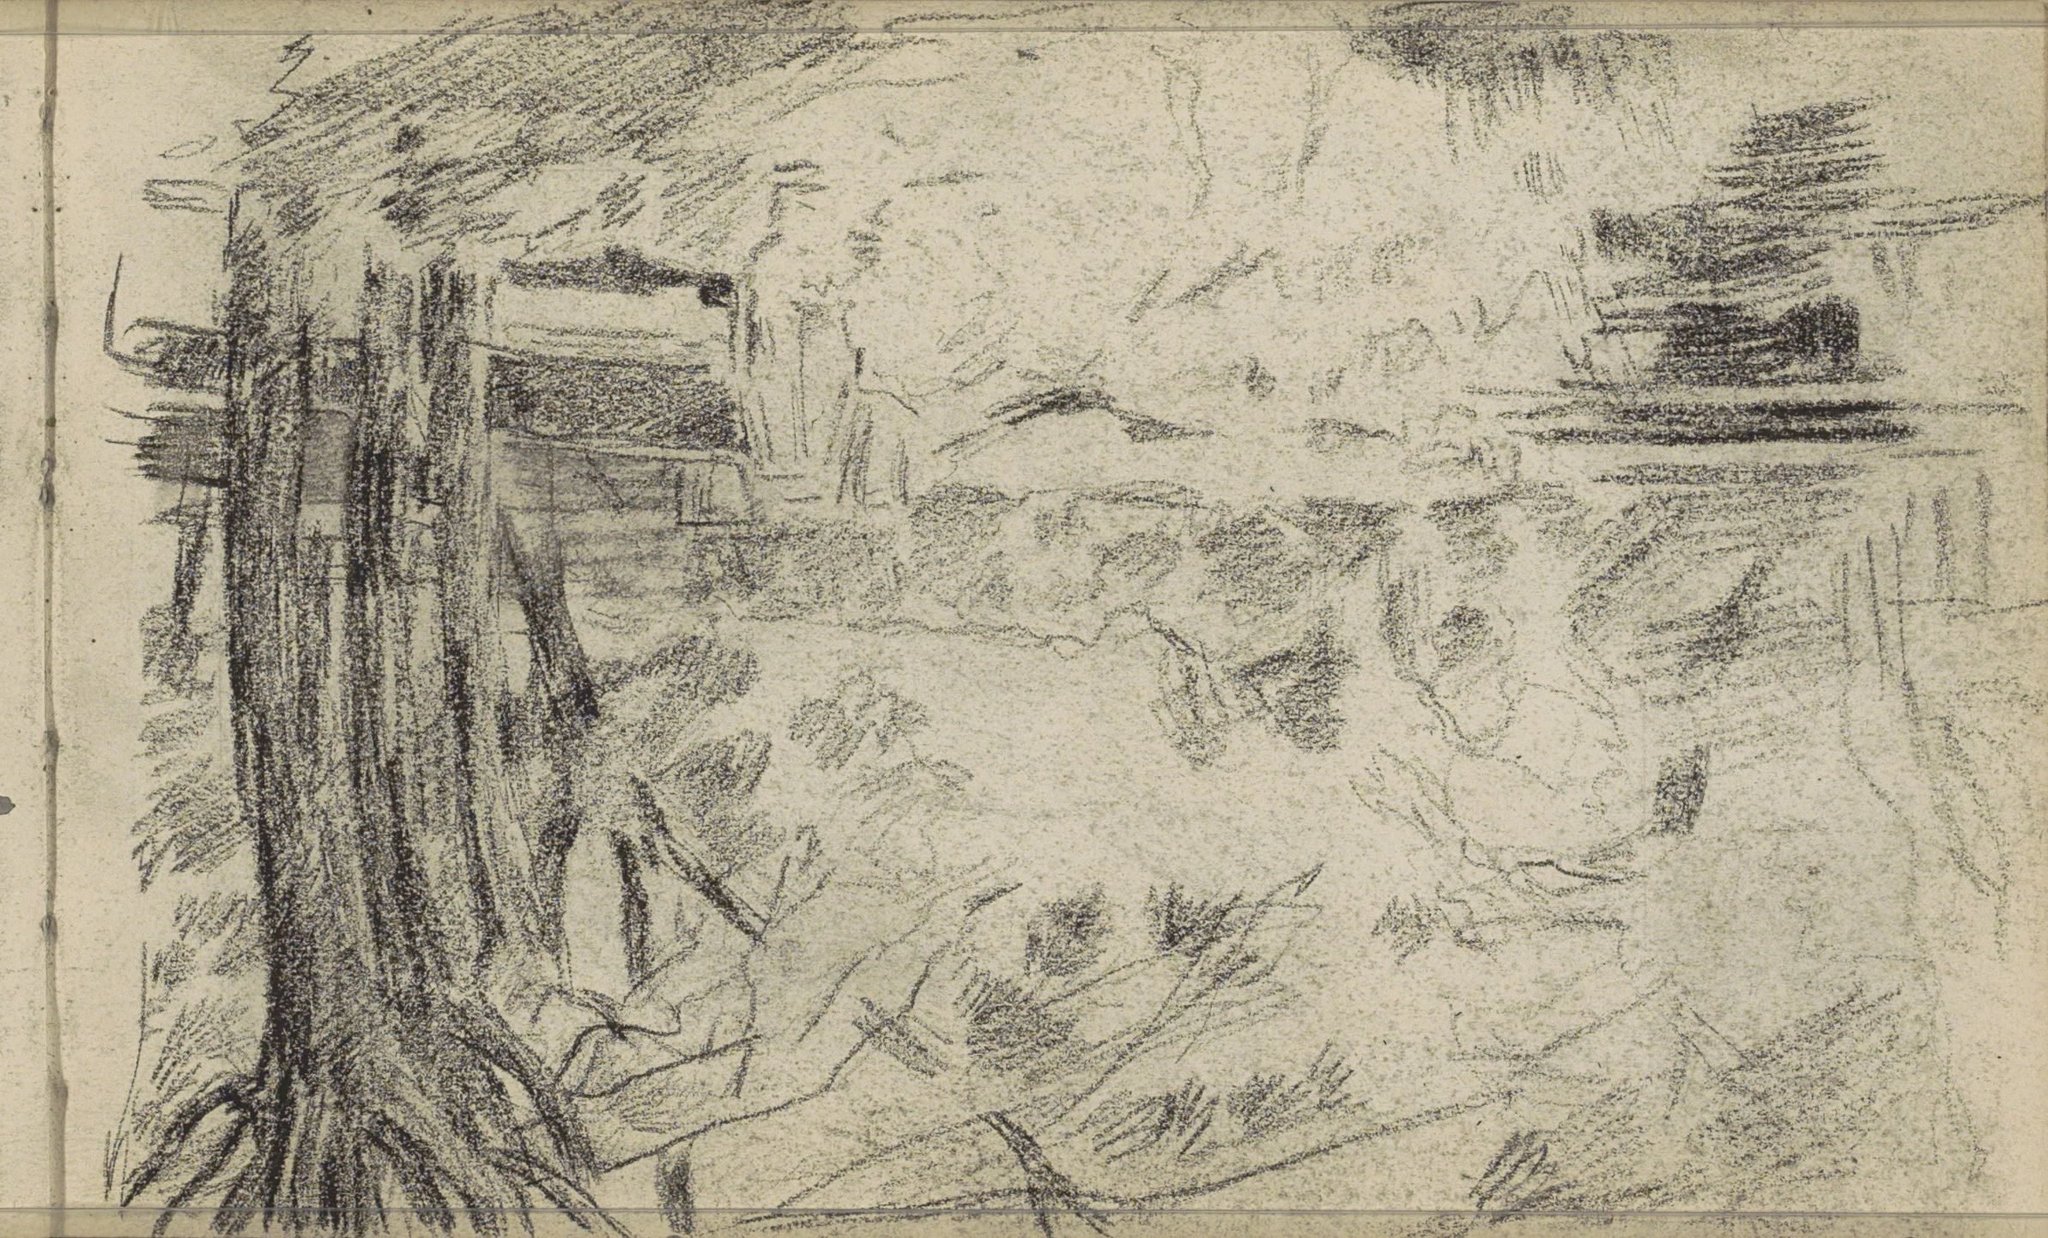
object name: sketchbook leaf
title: Landschap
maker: johan antonie de jonge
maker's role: draughtsman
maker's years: 1864-1927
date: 1901-1927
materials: chalk, paper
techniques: stumping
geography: south holland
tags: trees, landscapes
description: Landschap. Blad 24 recto uit een schetsboek met 45 bladen.